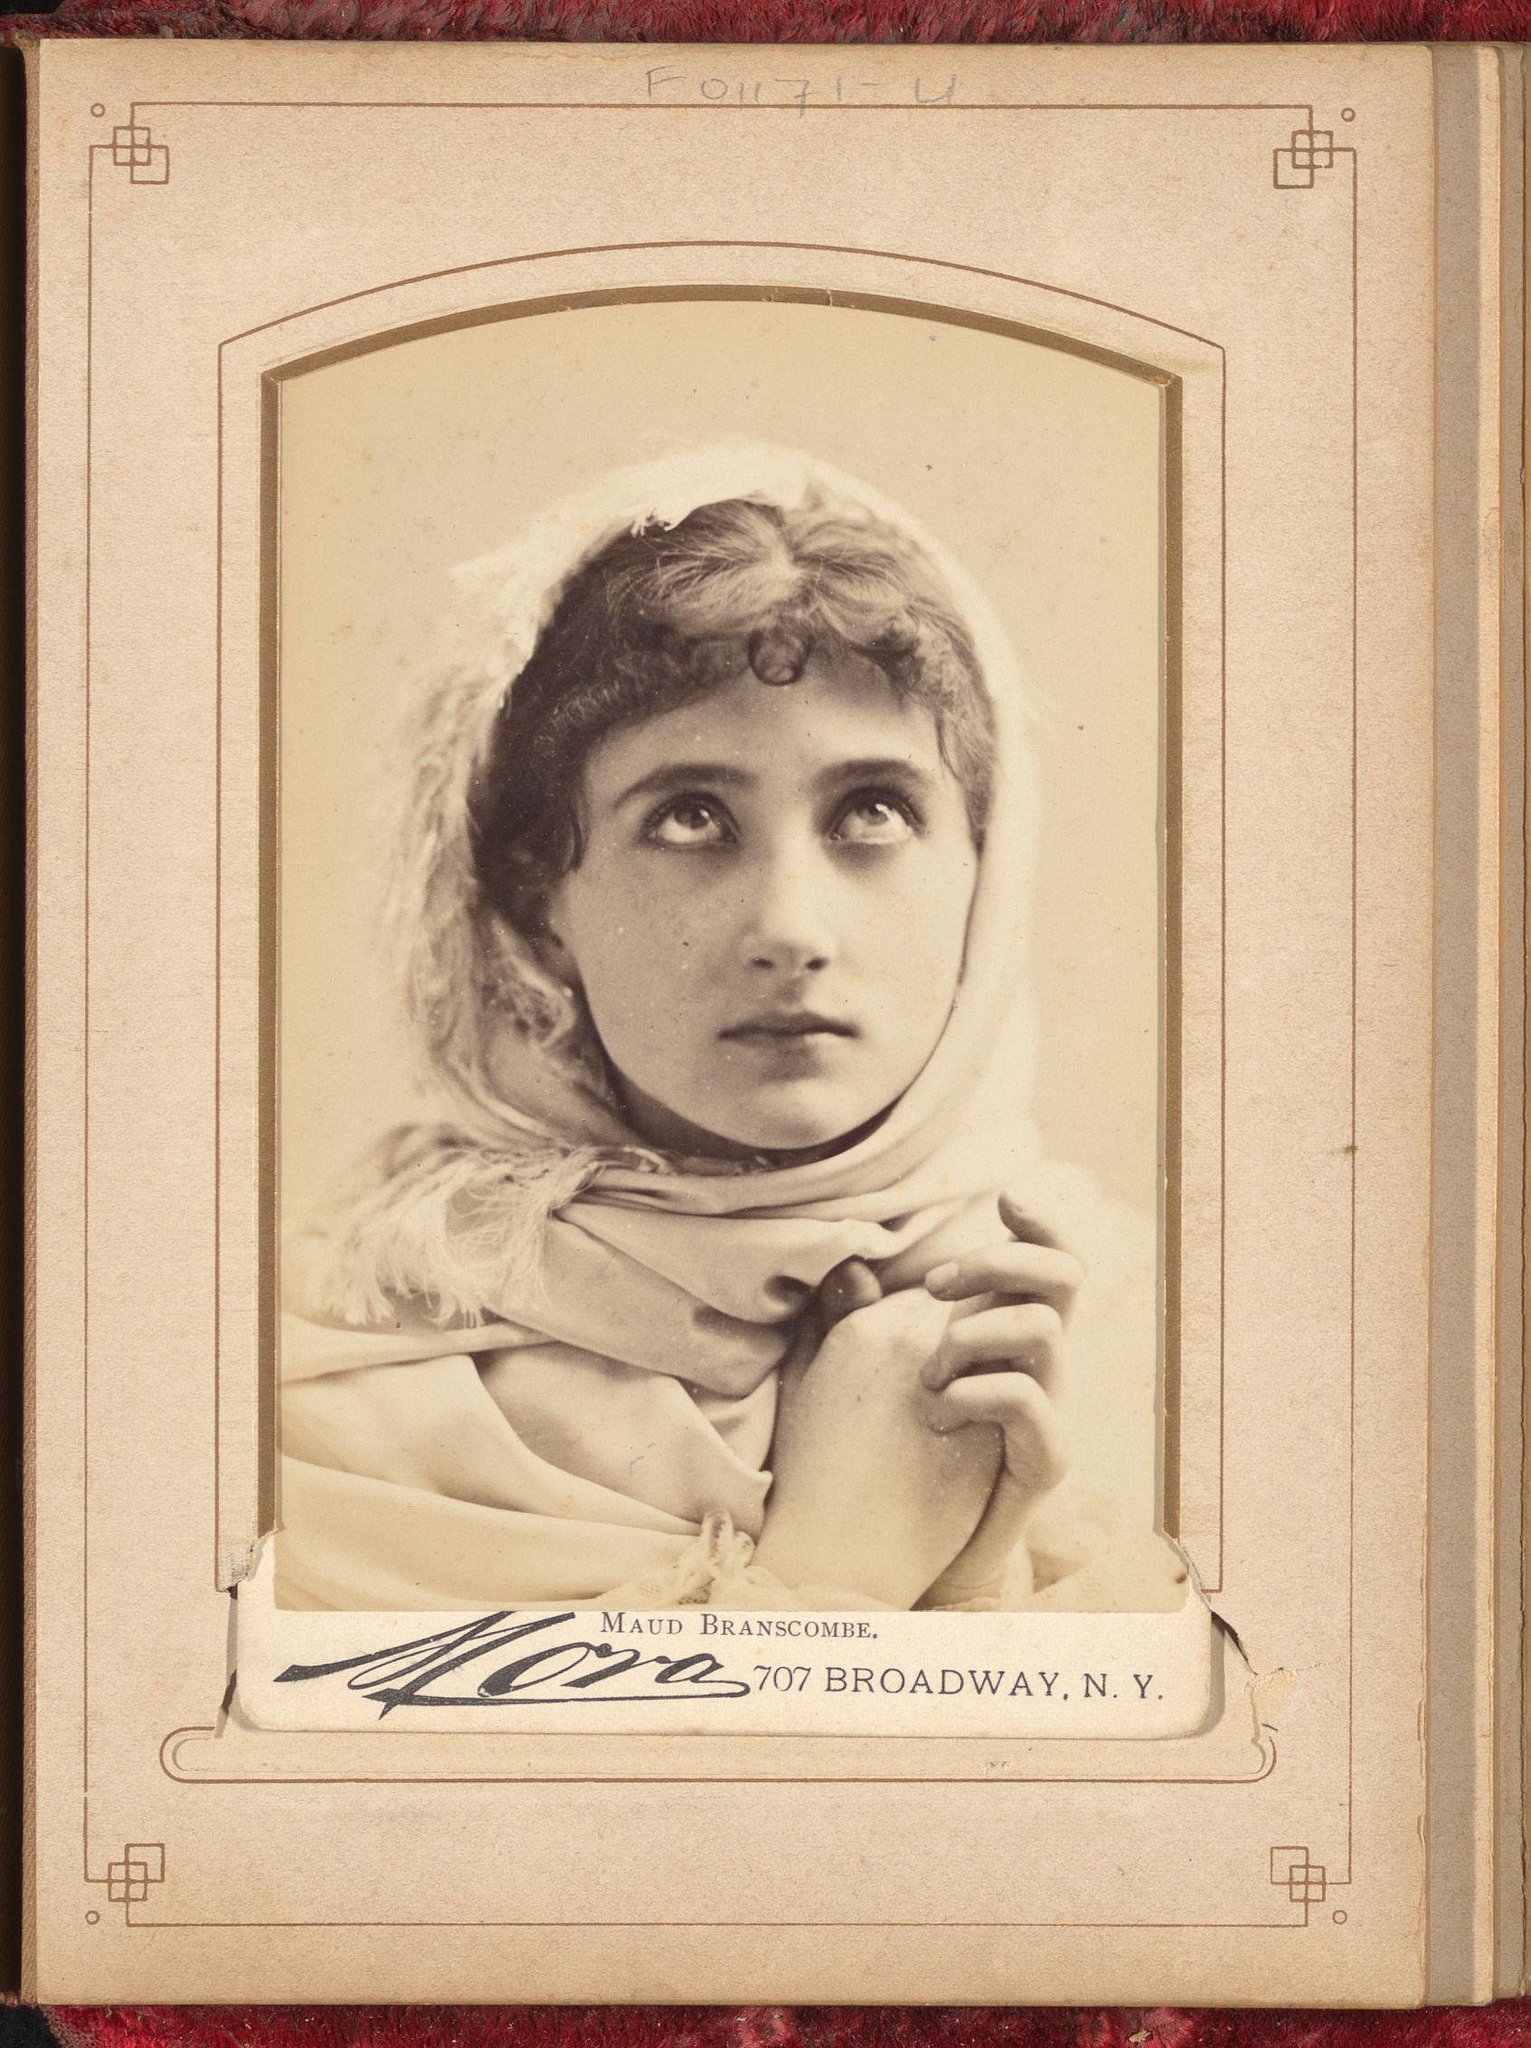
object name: photograph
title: Maud Branscombe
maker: josé maria mora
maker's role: fotograaf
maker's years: 1849-1926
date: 1870-1900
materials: cardboard, photographic support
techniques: albumen print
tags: adult woman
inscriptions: name: ‘Mora 707 Broadway, N.Y.’